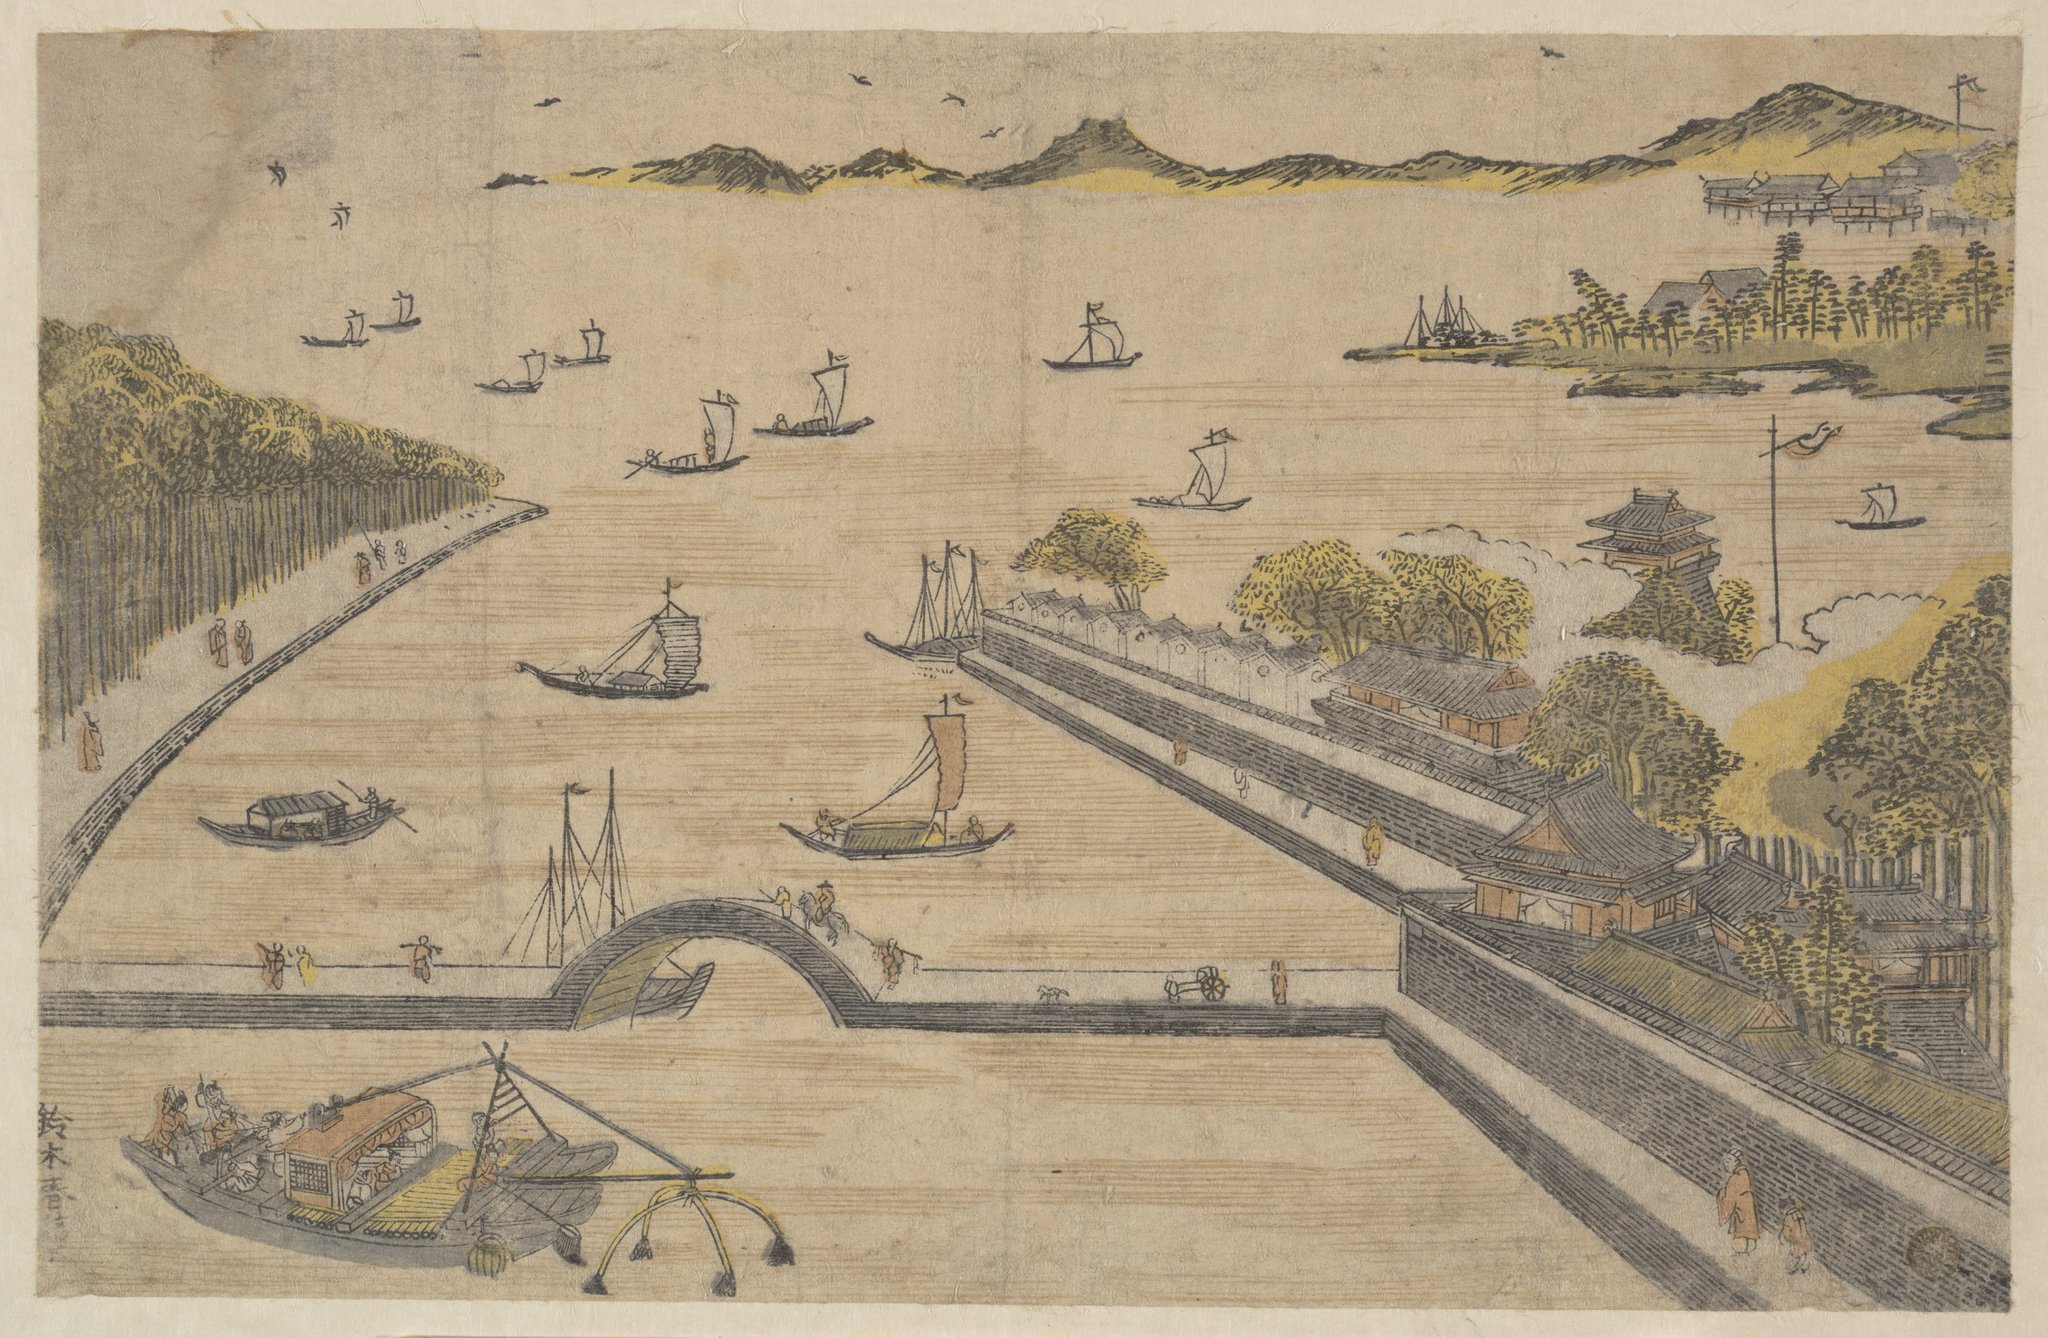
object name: print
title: View of Fukagawa, Edo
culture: japanese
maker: suzuki harunobu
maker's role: artist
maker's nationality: japanese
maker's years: 1725-1770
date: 1764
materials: ink, paper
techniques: woodblock print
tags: bridges,landscapes,boats